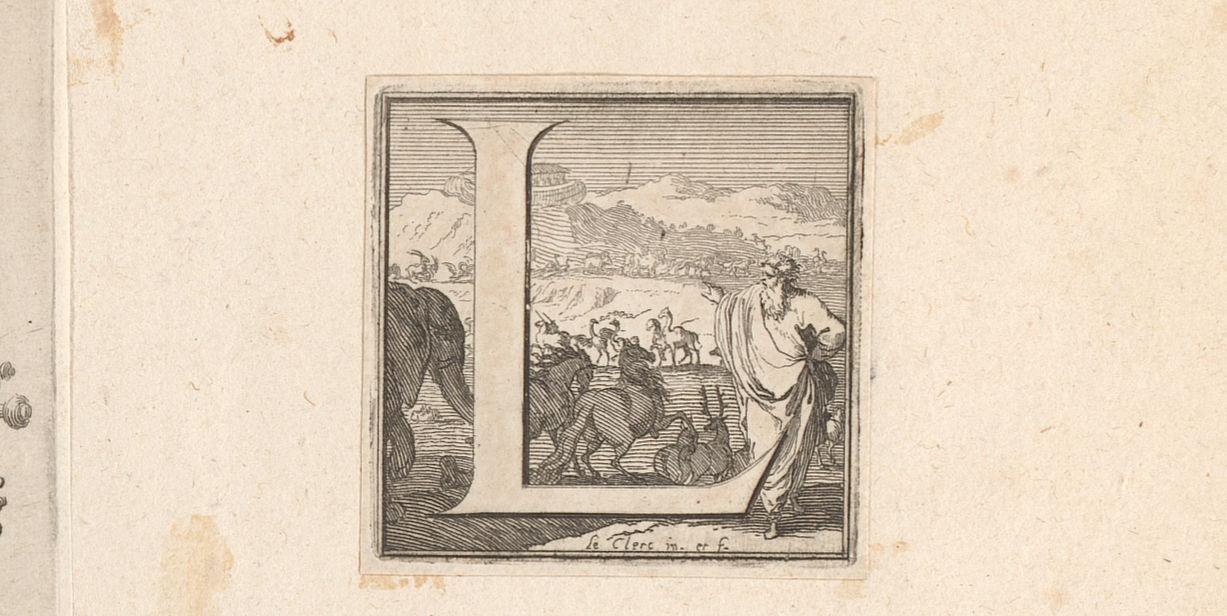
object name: print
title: Initiaal 'L' met Noach en de dieren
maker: sébastien leclerc (i)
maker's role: print maker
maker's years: 1637-1714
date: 1671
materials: paper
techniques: etching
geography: paris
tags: initial, the gathering of the animals in pairs ~ story of noah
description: Prent uit: Perrault, Claude. Mémoires pour servir à l'histoire naturelle des animaux. Parijs: Imprimerie Royale, 1671.